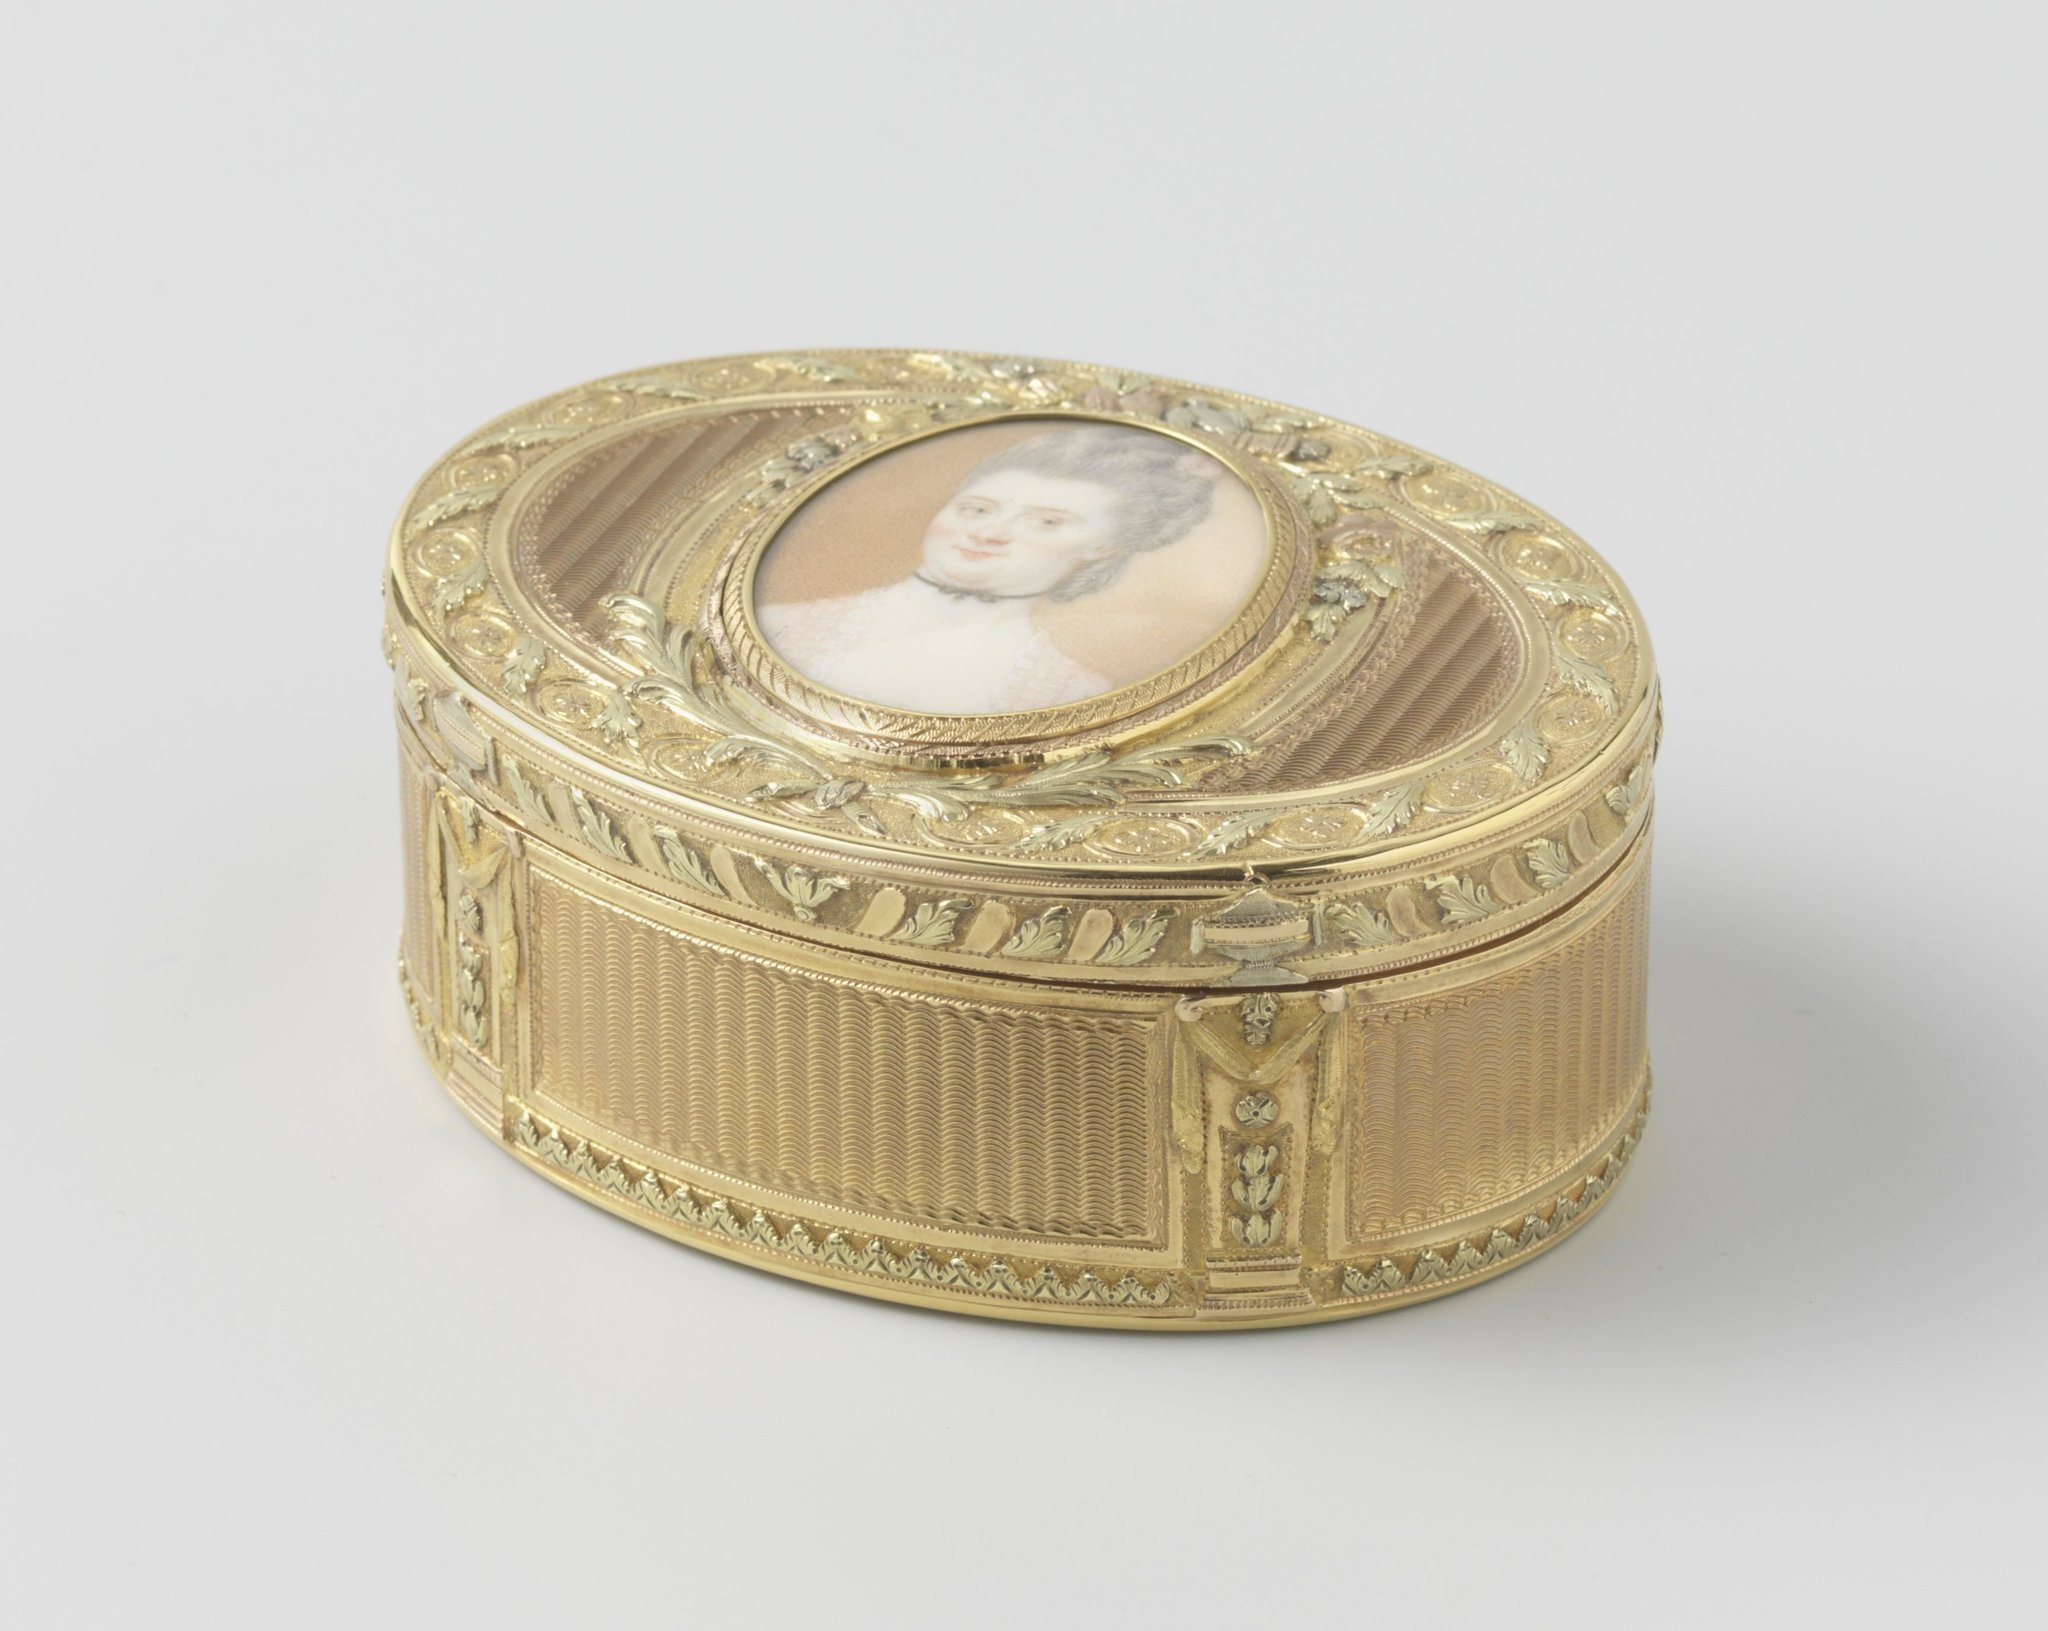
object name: snuffbox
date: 1773-1774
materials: glass, gold, ivory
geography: northern netherlands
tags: historical persons - bb - woman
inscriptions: date letter, maker's mark, countermark, duty mark, inscription: ‘324’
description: This snuffbox originally belonged to the Dutchman Jacob Hendrik de Ridder. The portrait is of Elisabeth Jacoba del Court, whom he married in 1774.